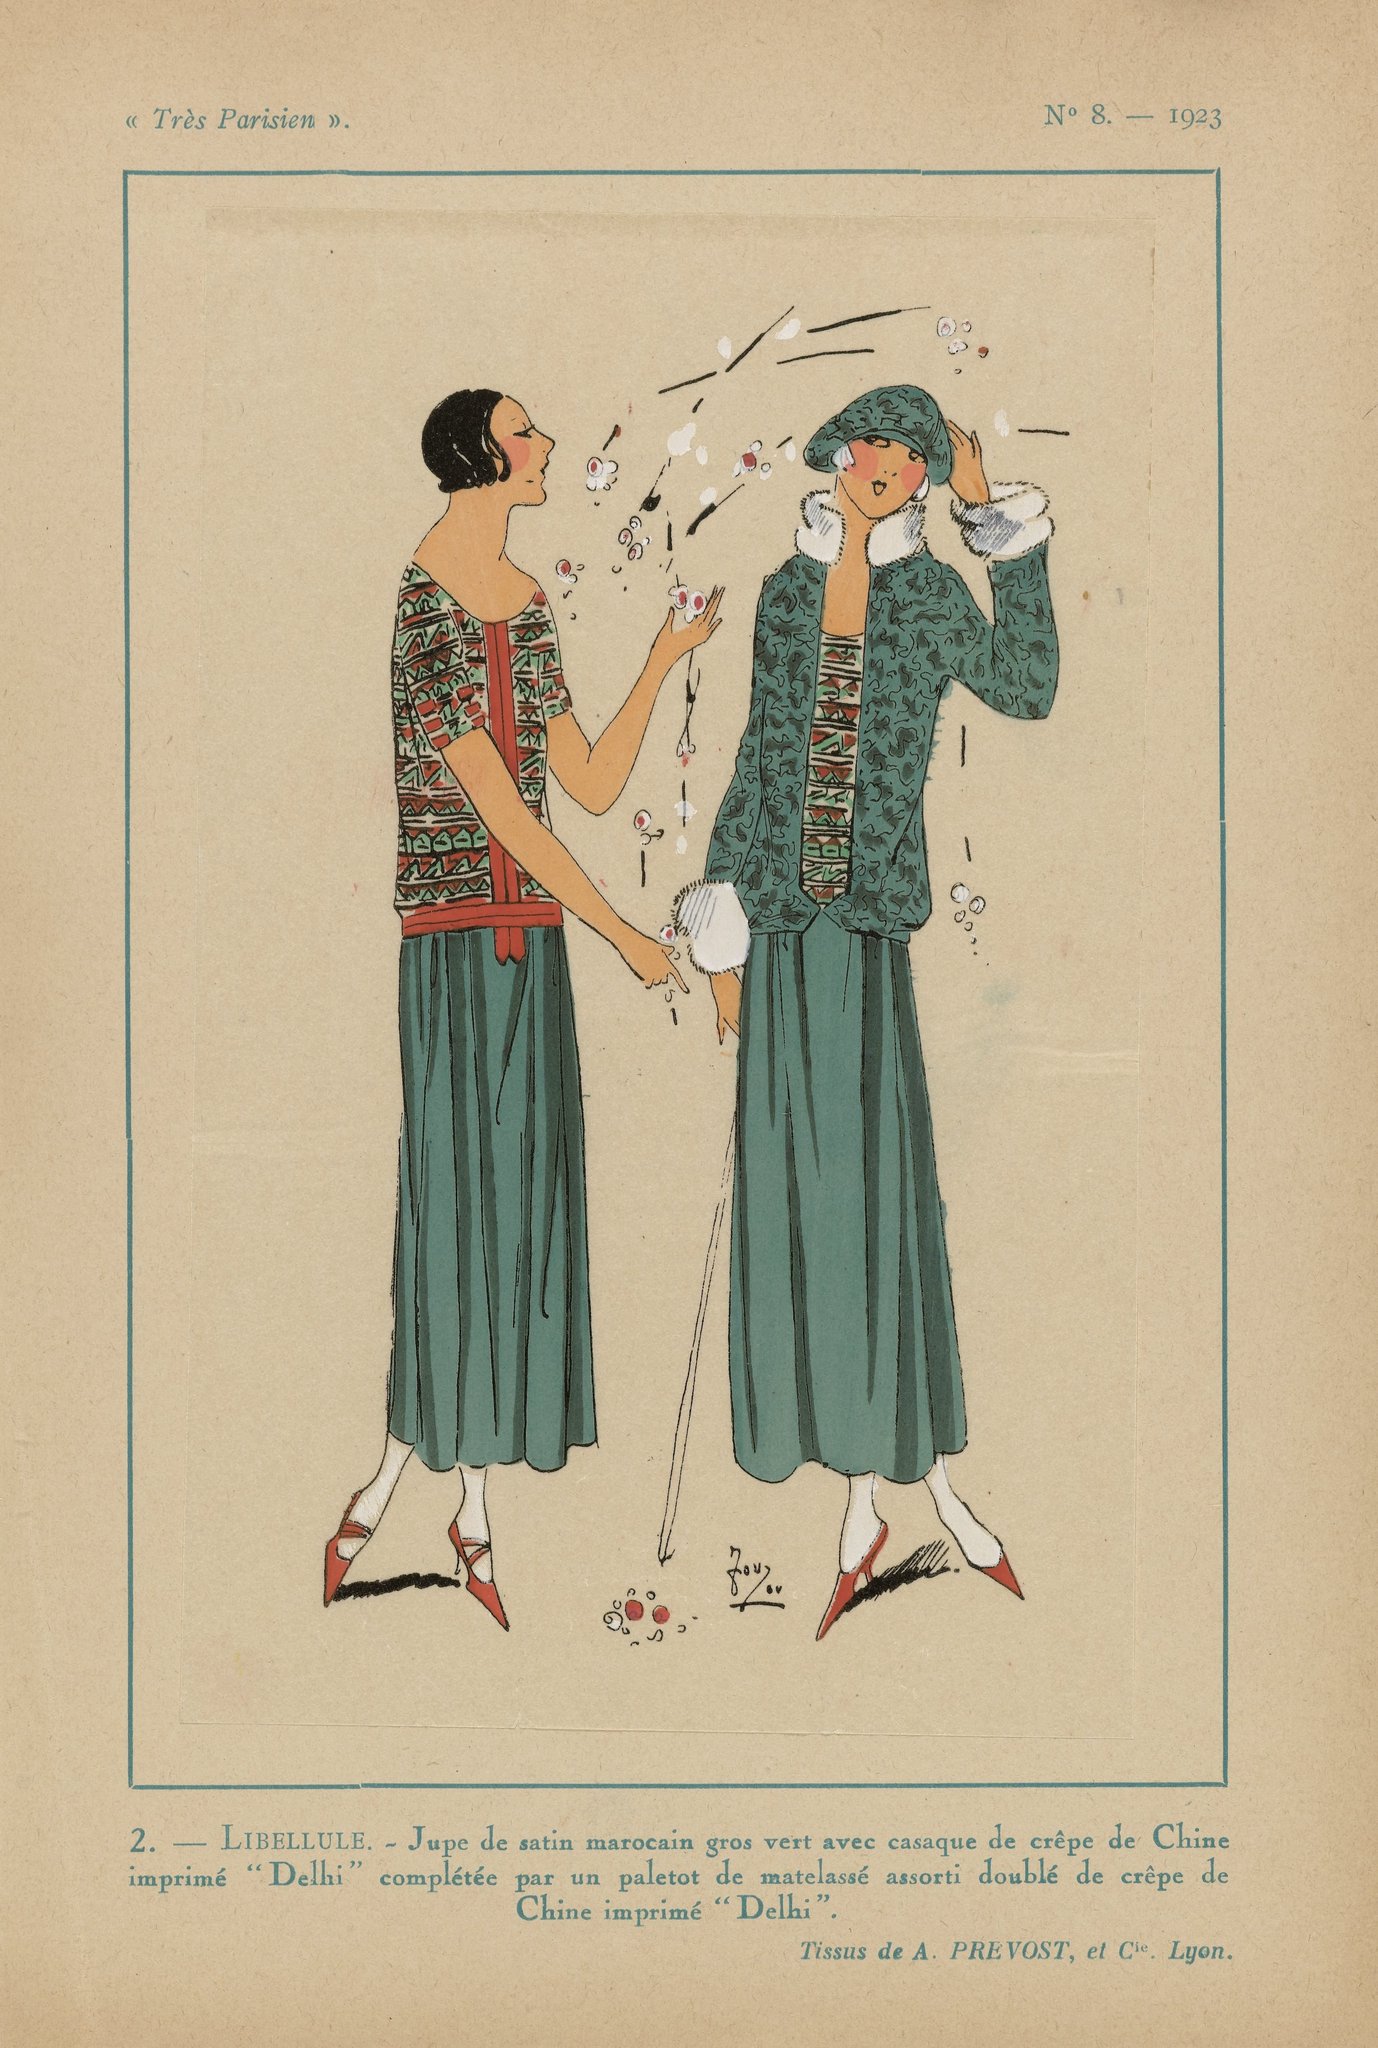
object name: fashion print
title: Très Parisien. La Mode, Le Chic, L’Elégance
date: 1923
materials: paper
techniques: hand coloring, letterpress printing, lithography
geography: lyon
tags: walking-stick, staff, cane (+ women's clothes), head-gear: beret (+ women's clothes), coat (+ women's clothes), coat: overcoat (+ women's clothes), fashion plates, skirt (+ women's clothes)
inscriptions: title: ‘Très Parisien / No 8. - 1923’, caption: ‘2. - LIBELLULE. - Jupe de satin marocain gros vert avec casaque de crêpe de Chine imprimé "Delhi" complétée par un paletot de matelassé assorti doublé de crêpe de Chine imprimé "Delhi". / Tissus de A. PREVOST, et Cie. Lyon’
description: Très Parisien promoted itself as chic and elegant. Between 1920 and 1936 it presented creations by such couturiers as Chéruit, Premet, Philip et Gaston, and Lanvin. The young, svelte models are all ultra-modern, shown talking on the phone, smoking and playing tennis. The illustrations also show that over the course of the 1920s, skirt lengths had risen to just below the knee, before dropping back down to calf length in the 1930s. The small plates were printed on transparent paper using a stencilling technique known as en pochoir and then hand coloured; many of them are unsigned. The signature ‘Joujou’ belonged to Germaine Paule Joumard, who was the director of Très Parisien, as well as one of the magazine’s illustrators.